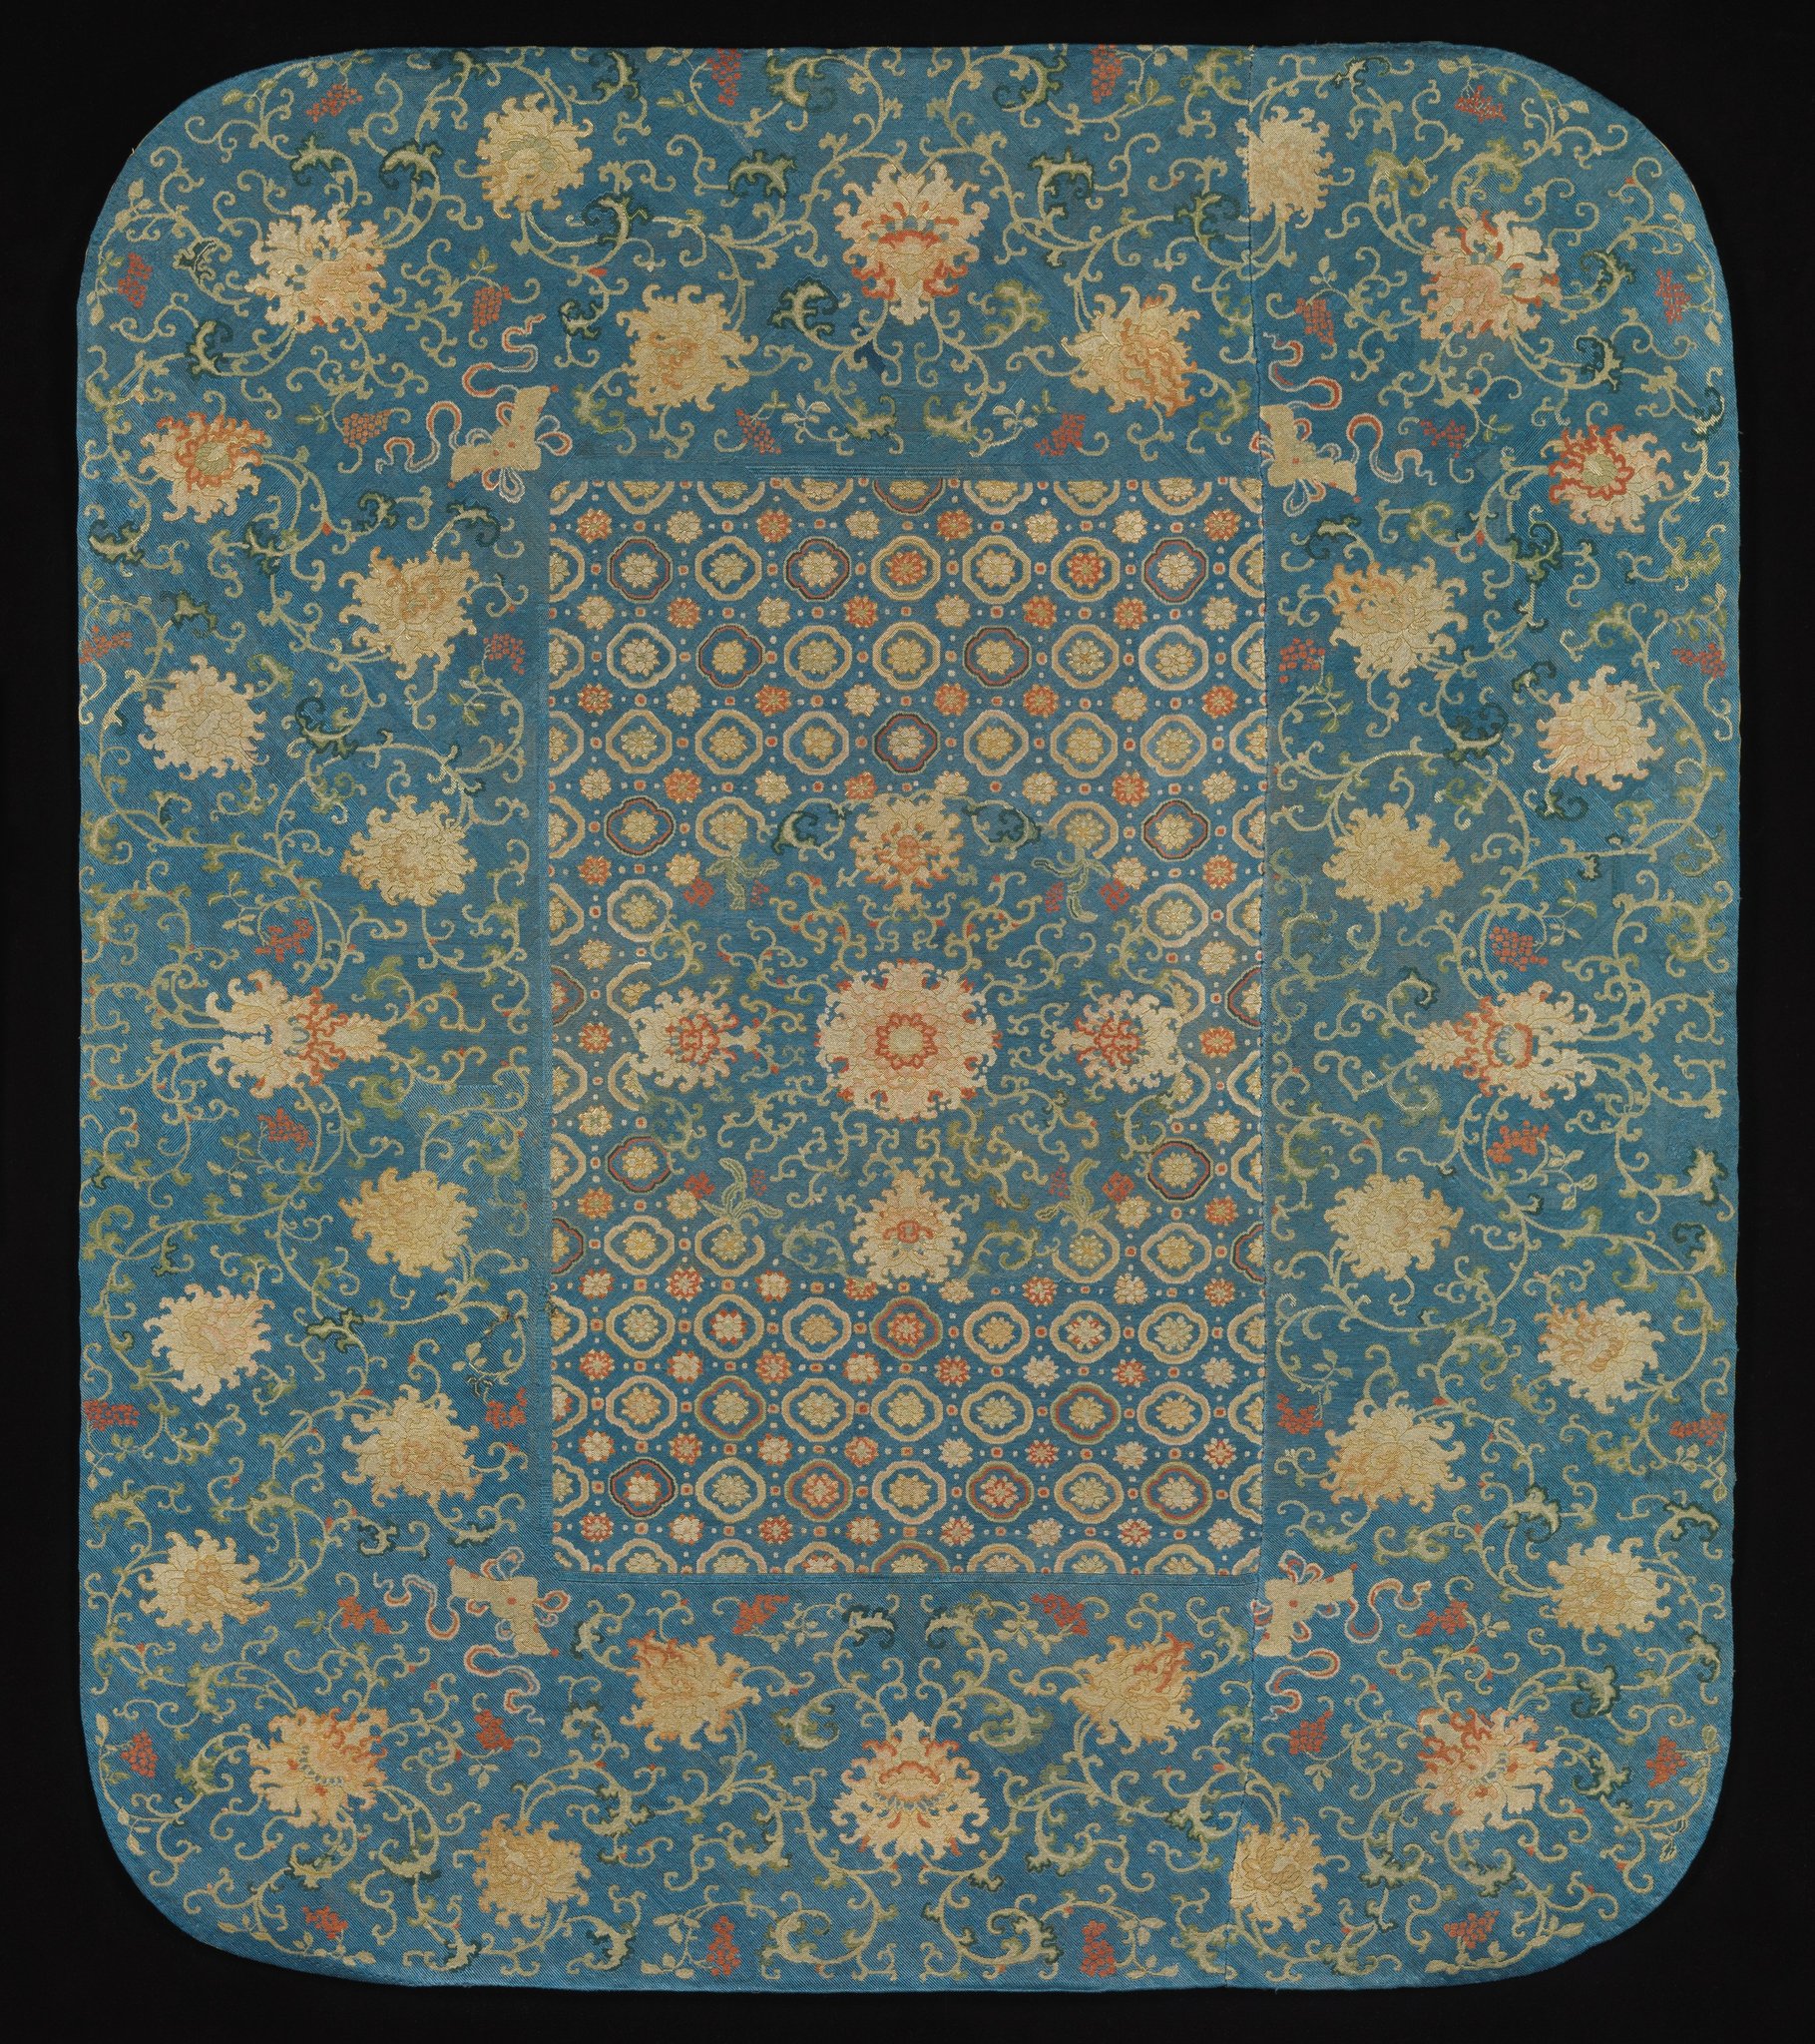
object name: furniture cover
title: Furniture Cover with Pattern of Flowers and Sonorous Stones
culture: chinese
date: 1701-1733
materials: textile, silk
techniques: embroidery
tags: flowers